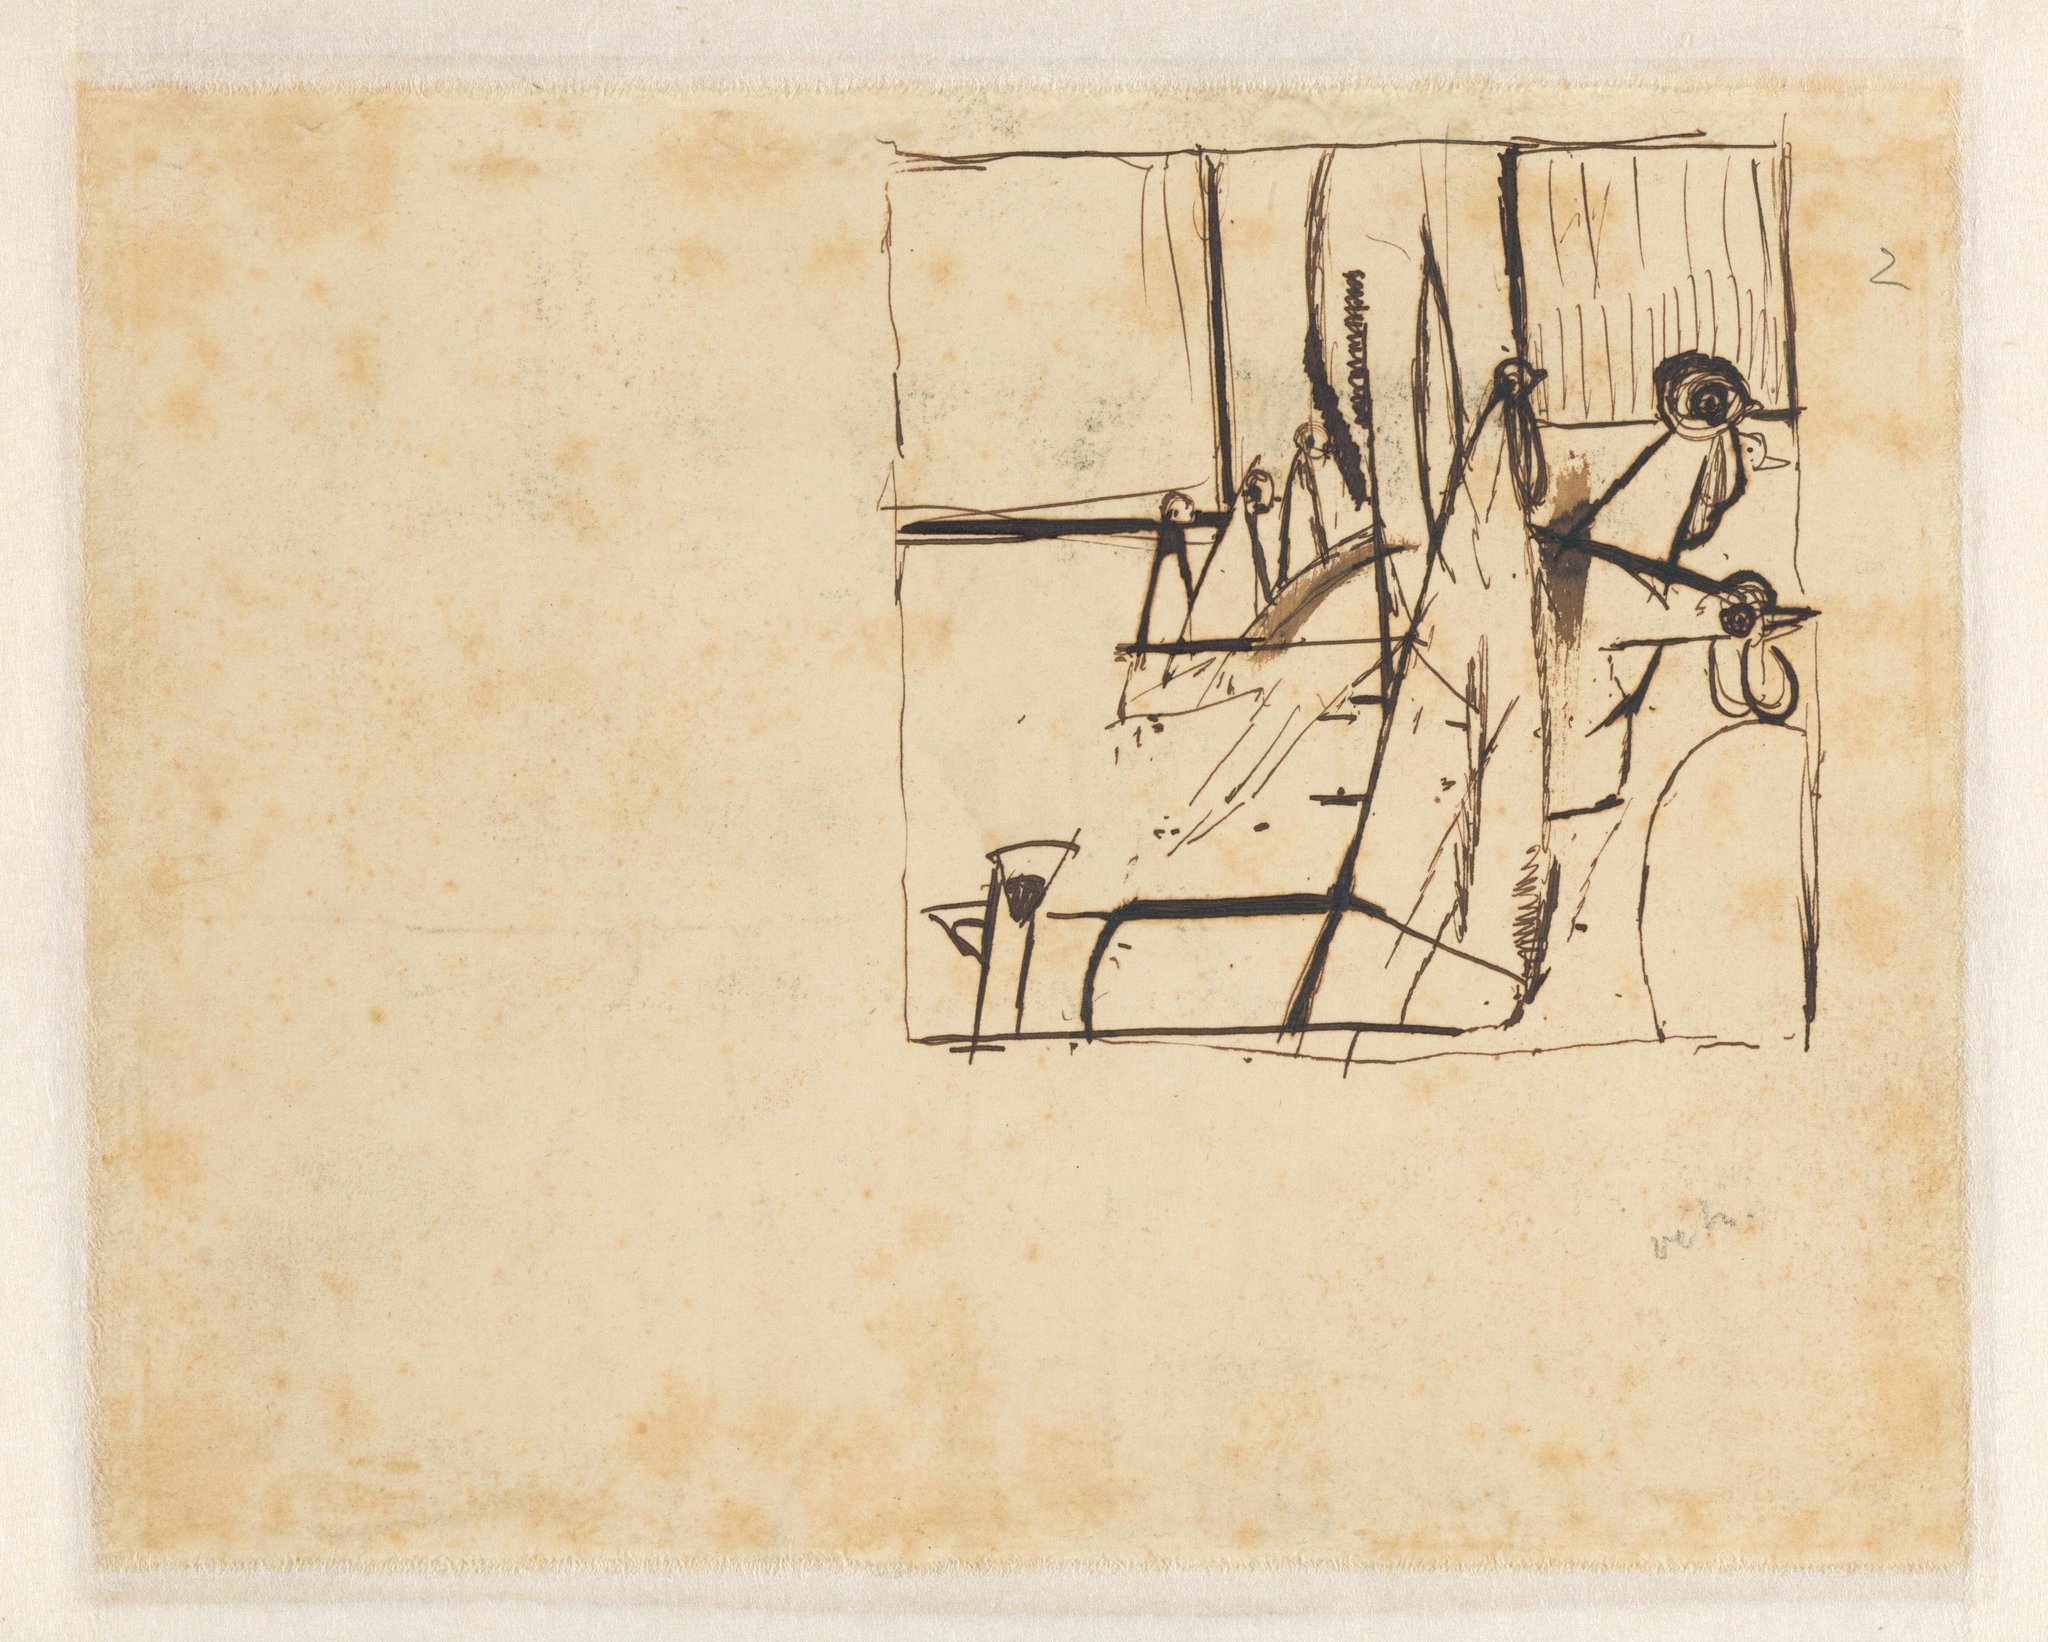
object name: drawing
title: Landschap met staande figuren en hanenkoppen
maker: herman kruyder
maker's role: draughtsman, print maker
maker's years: 1881-1935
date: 1891-1935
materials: ink, paper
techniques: pen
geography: netherlands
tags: standing figure, landscapes, fowl (cock, hen, chicken, etc.)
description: Op hetzelfde opzetvel zit een karton bevestigd met daarop hardboard en papier geplakt met informatie over tentoonstellingen waar deze tekening deel van heeft uitgemaakt.